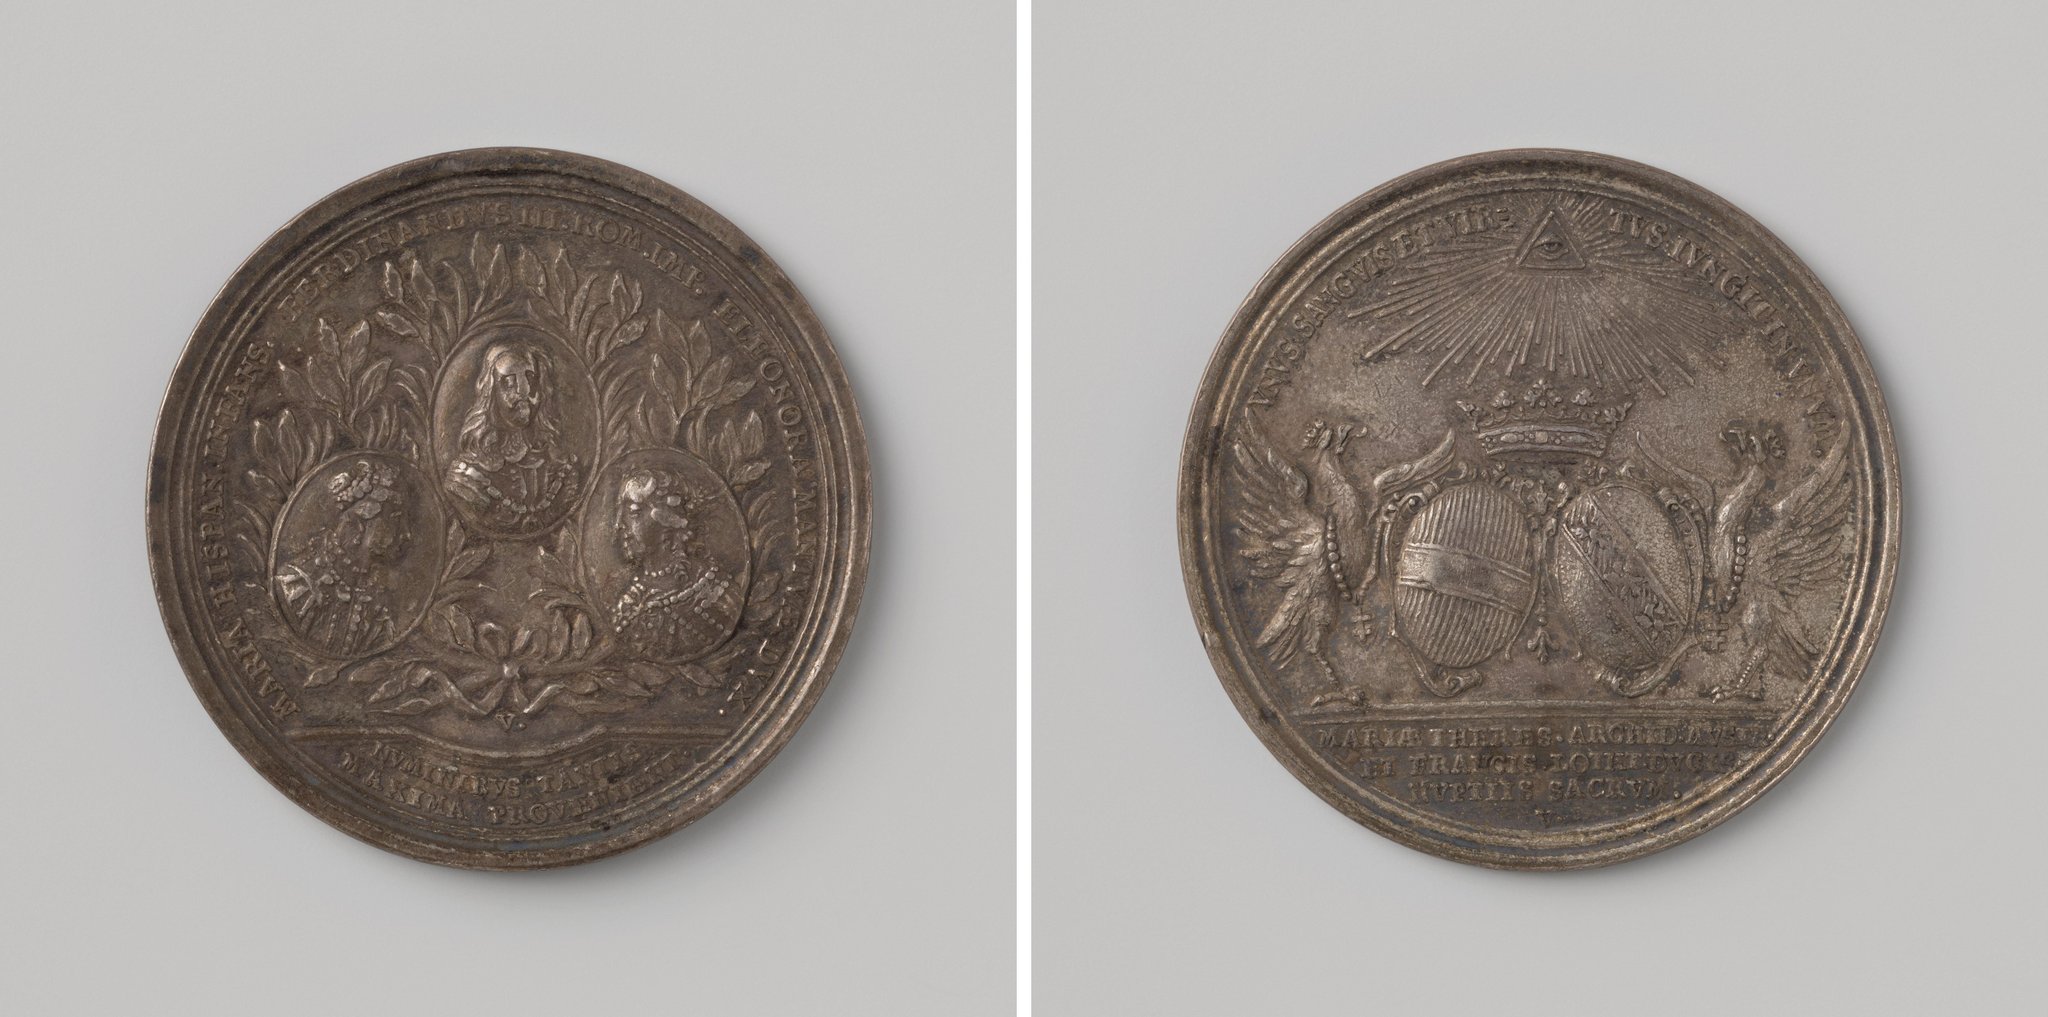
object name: history medal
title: Huwelijk van Frans Stephen, hertog van Lotharingen en Maria Theresia, aartshertogin van Oostenrijk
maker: georg wilhelm vestner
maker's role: medailleur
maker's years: 1677-1740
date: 1736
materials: silver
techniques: striking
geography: nuremberg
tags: ferdinand iii (duits keizer), vienna, maria theresia (rooms-duits keizerin), frans i stefan (duits keizer)